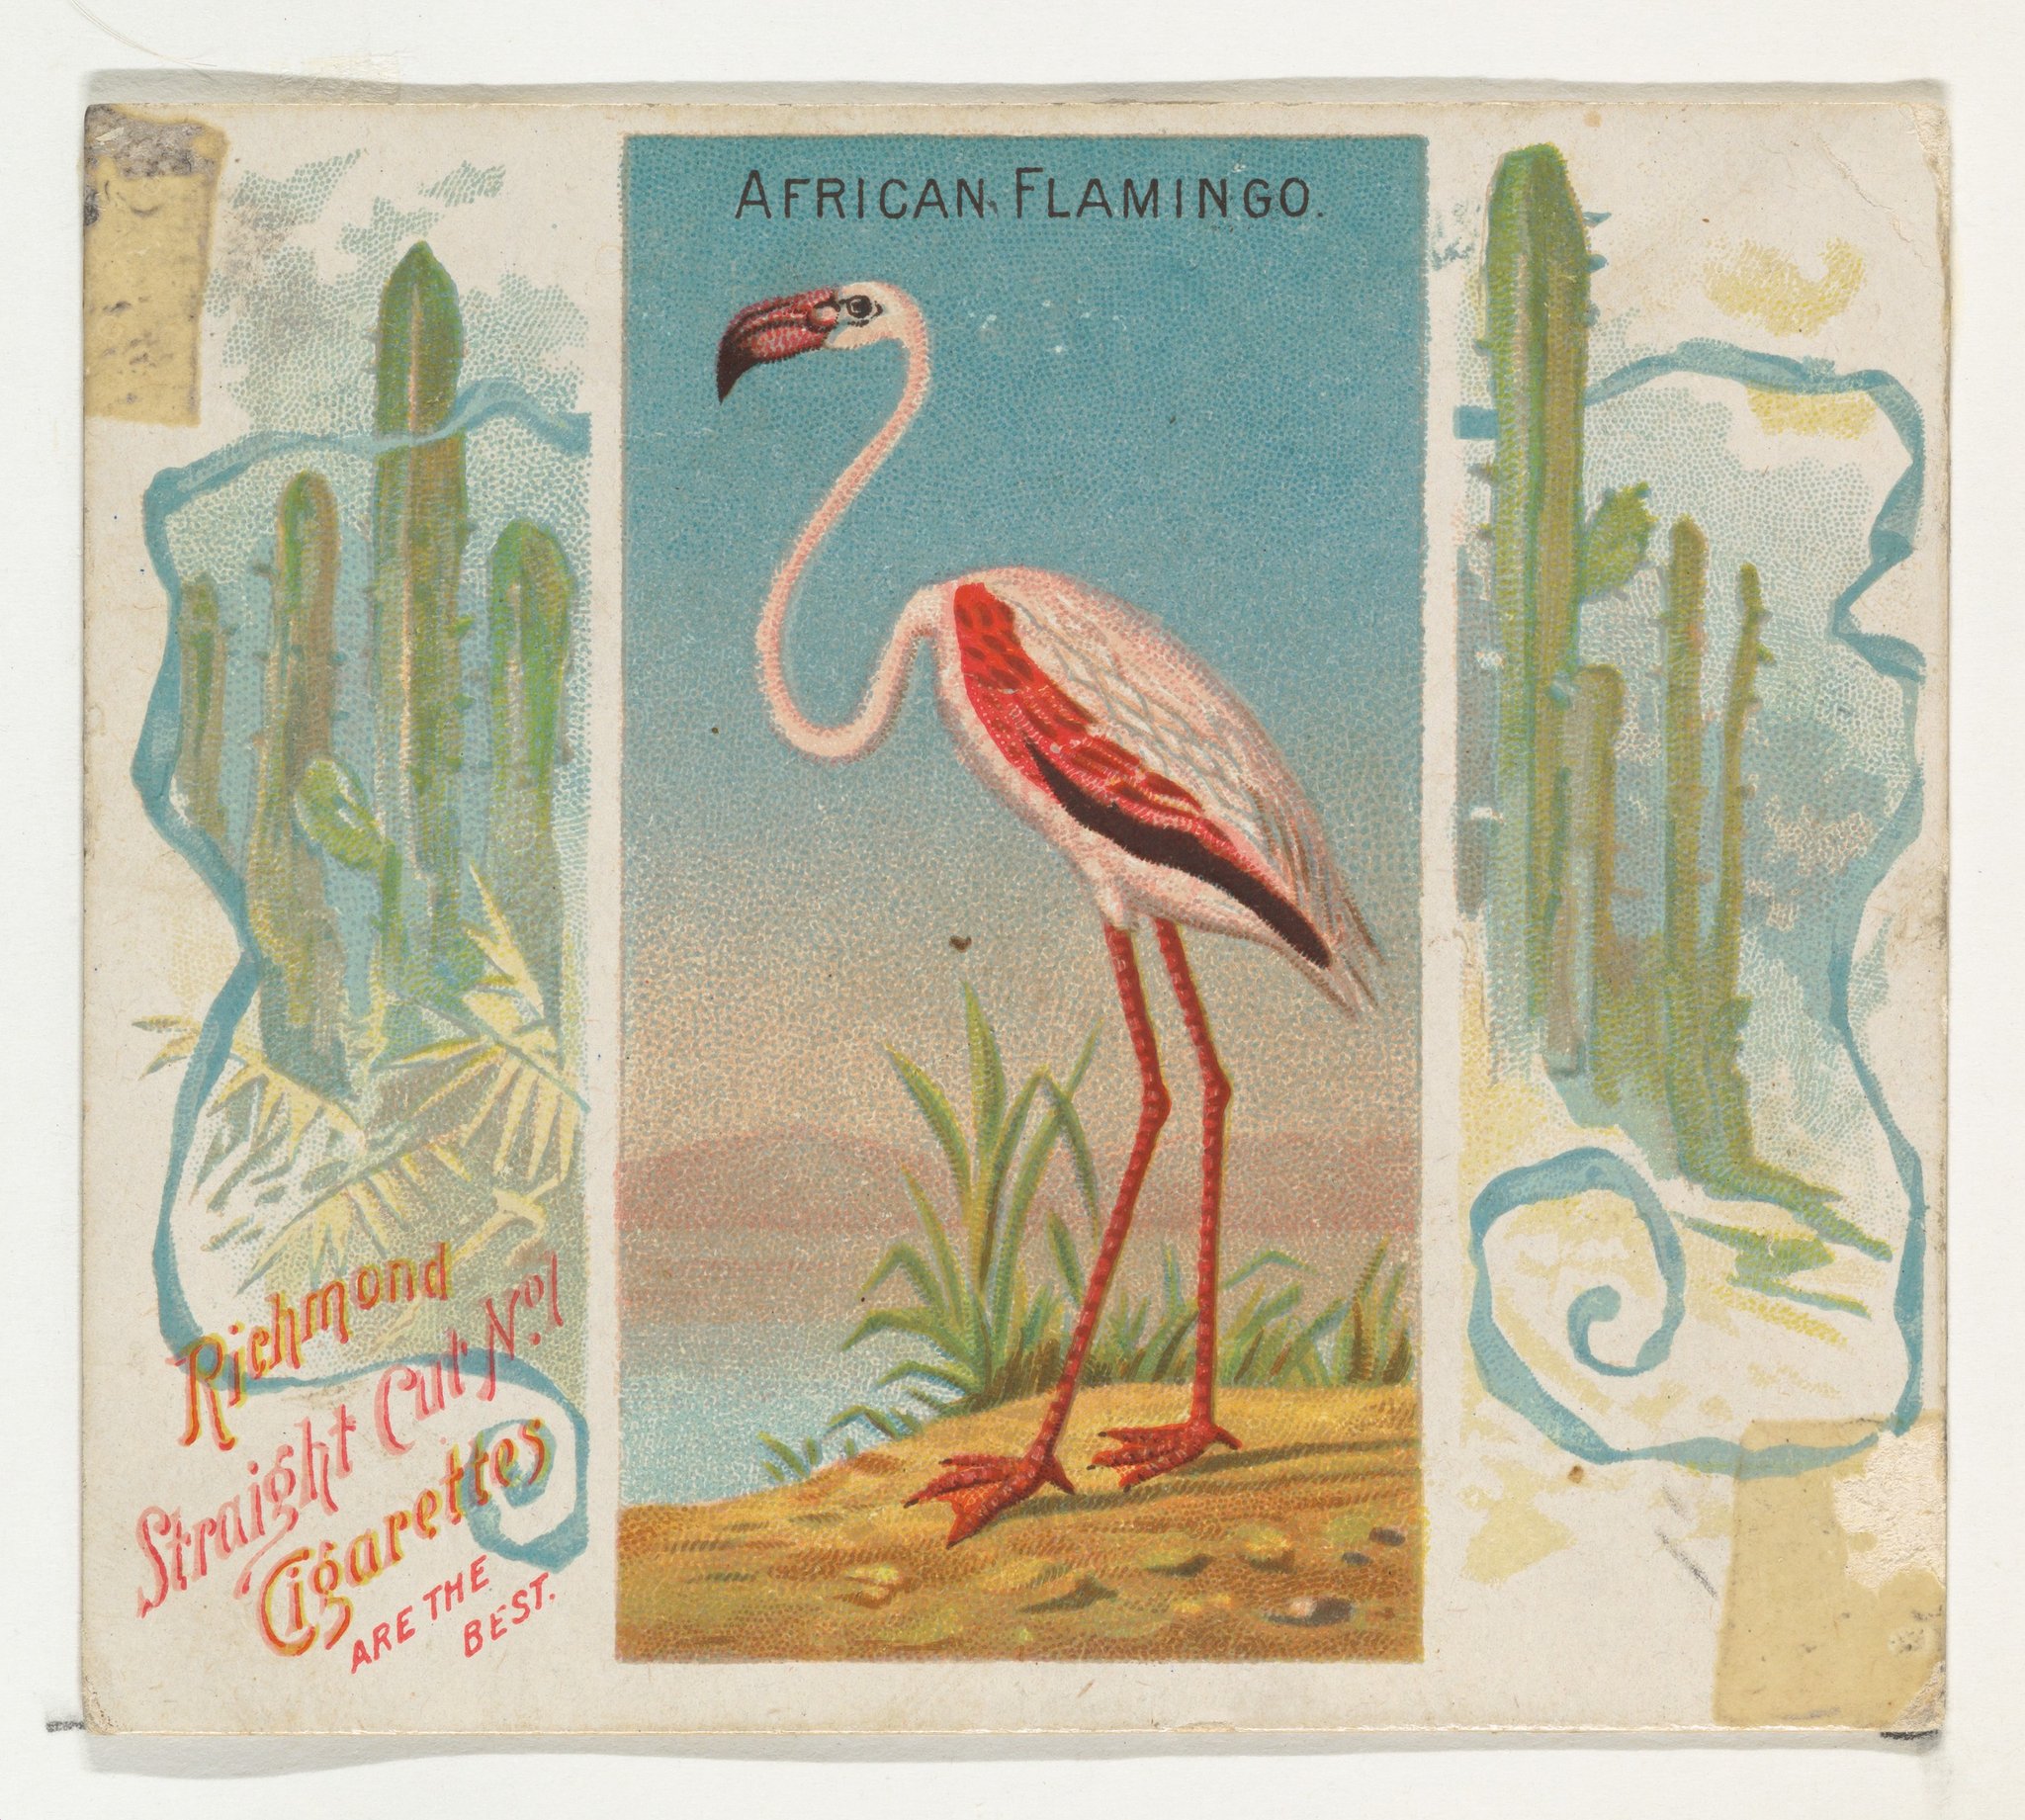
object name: print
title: African Flamingo, from Birds of the Tropics series (N38) for Allen & Ginter Cigarettes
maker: allen & ginter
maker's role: publisher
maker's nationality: american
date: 1889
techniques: color lithograph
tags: birds